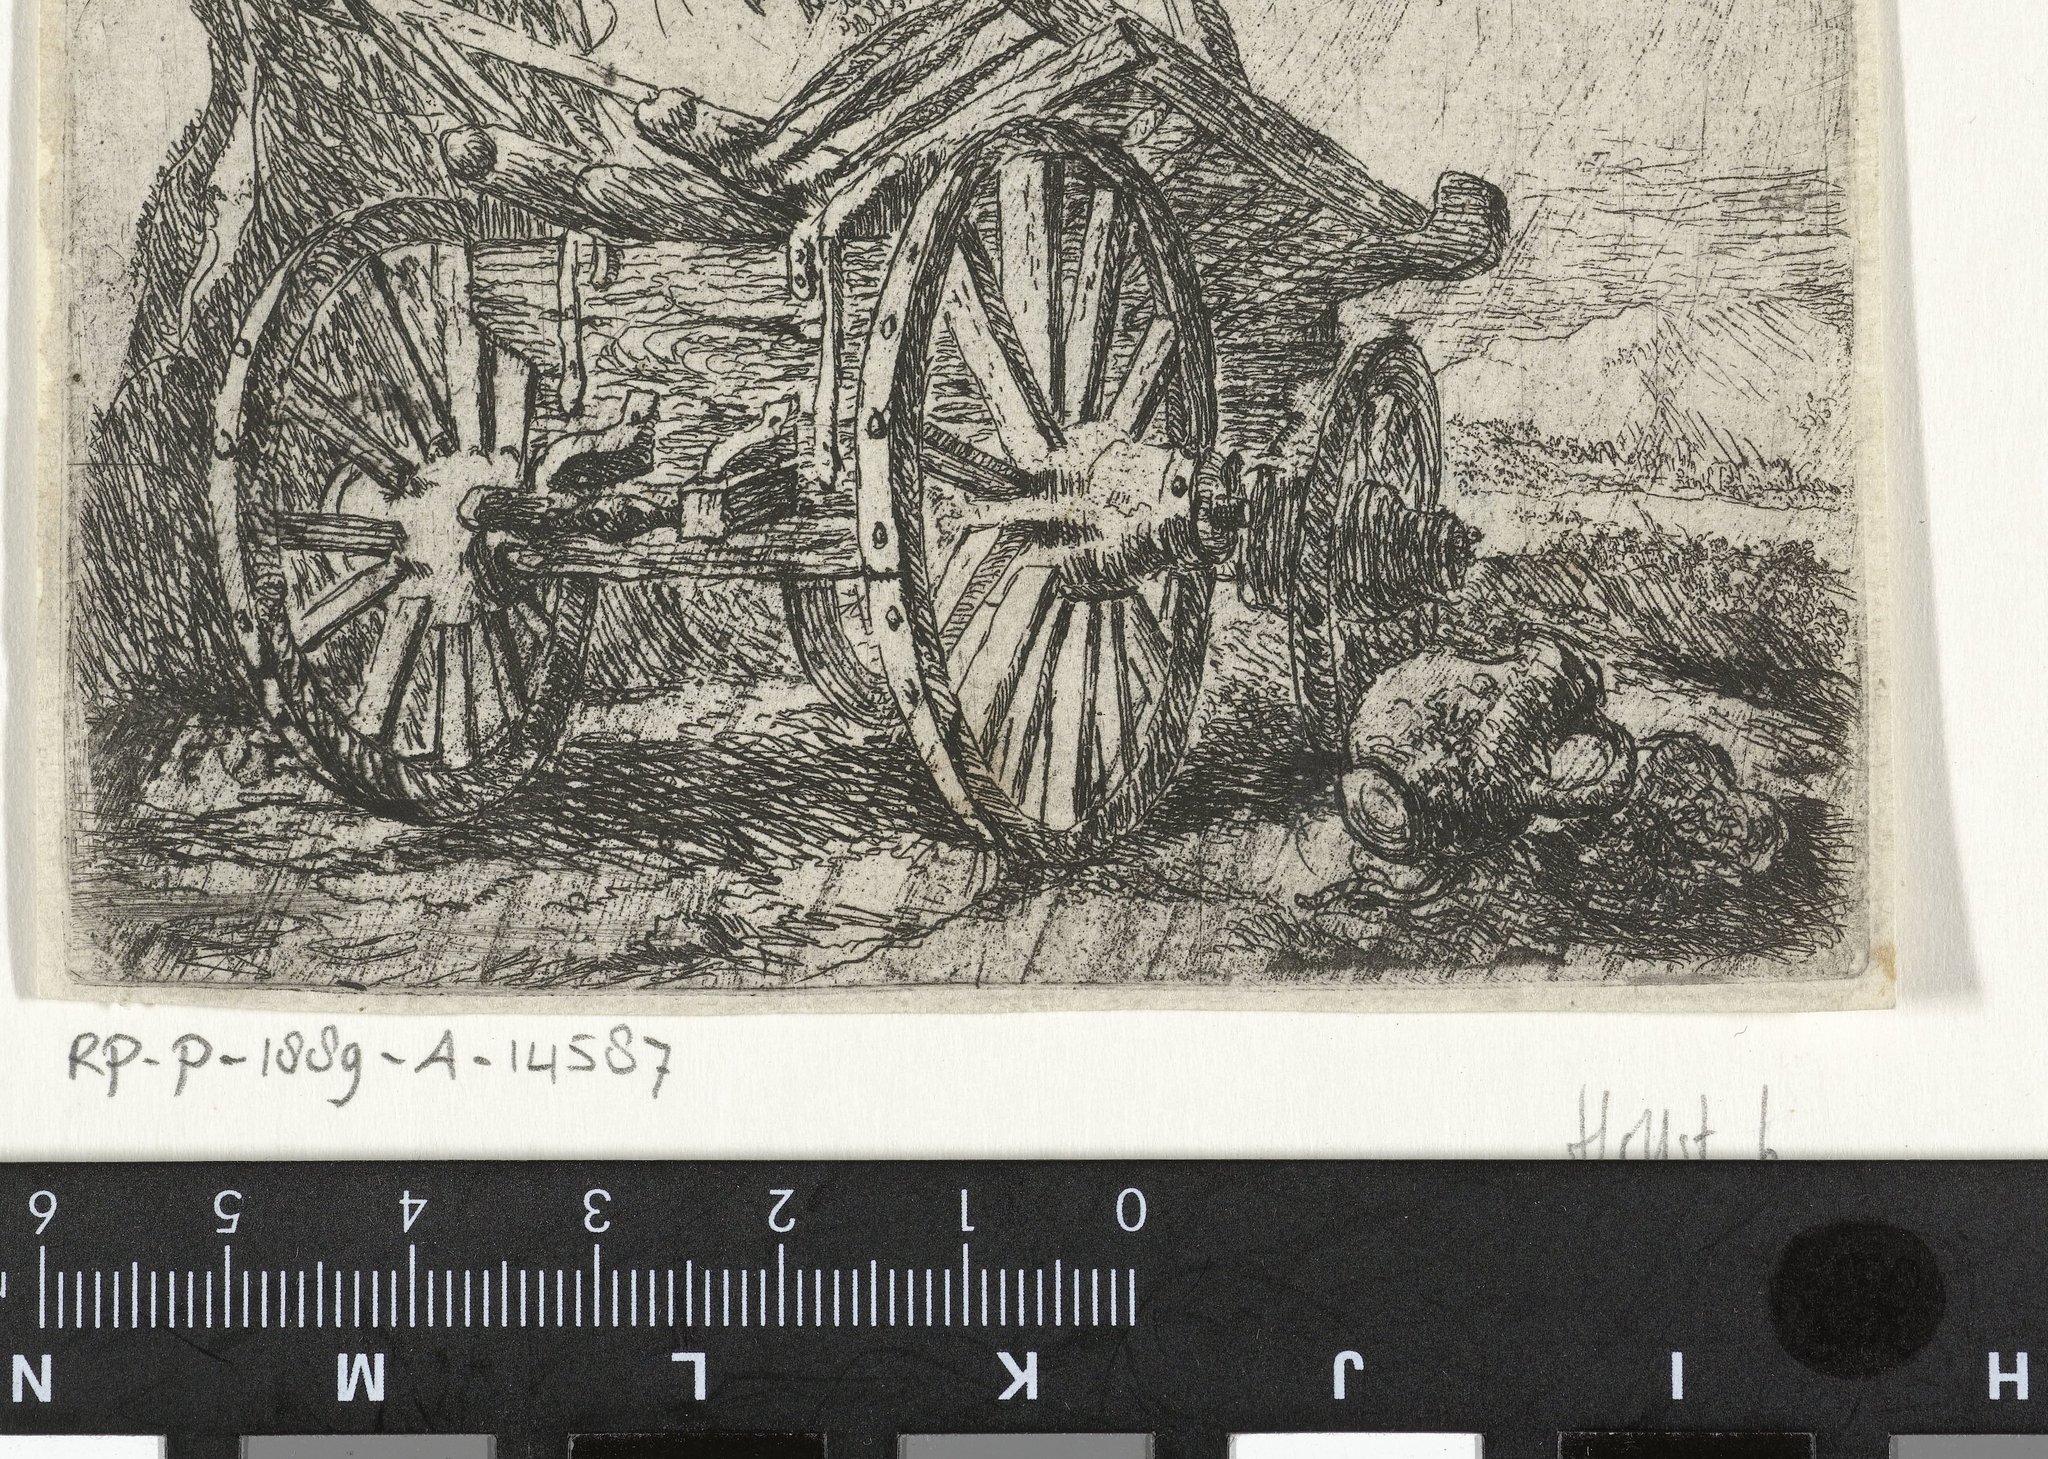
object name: print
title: Dieren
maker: joannes fijt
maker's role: draughtsman, print maker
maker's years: 1611-1661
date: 1621-1661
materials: paper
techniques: etching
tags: (farm) wagon, freight wagon, cart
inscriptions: collector's mark: Lugt 2228, collector's mark: Lugt 514